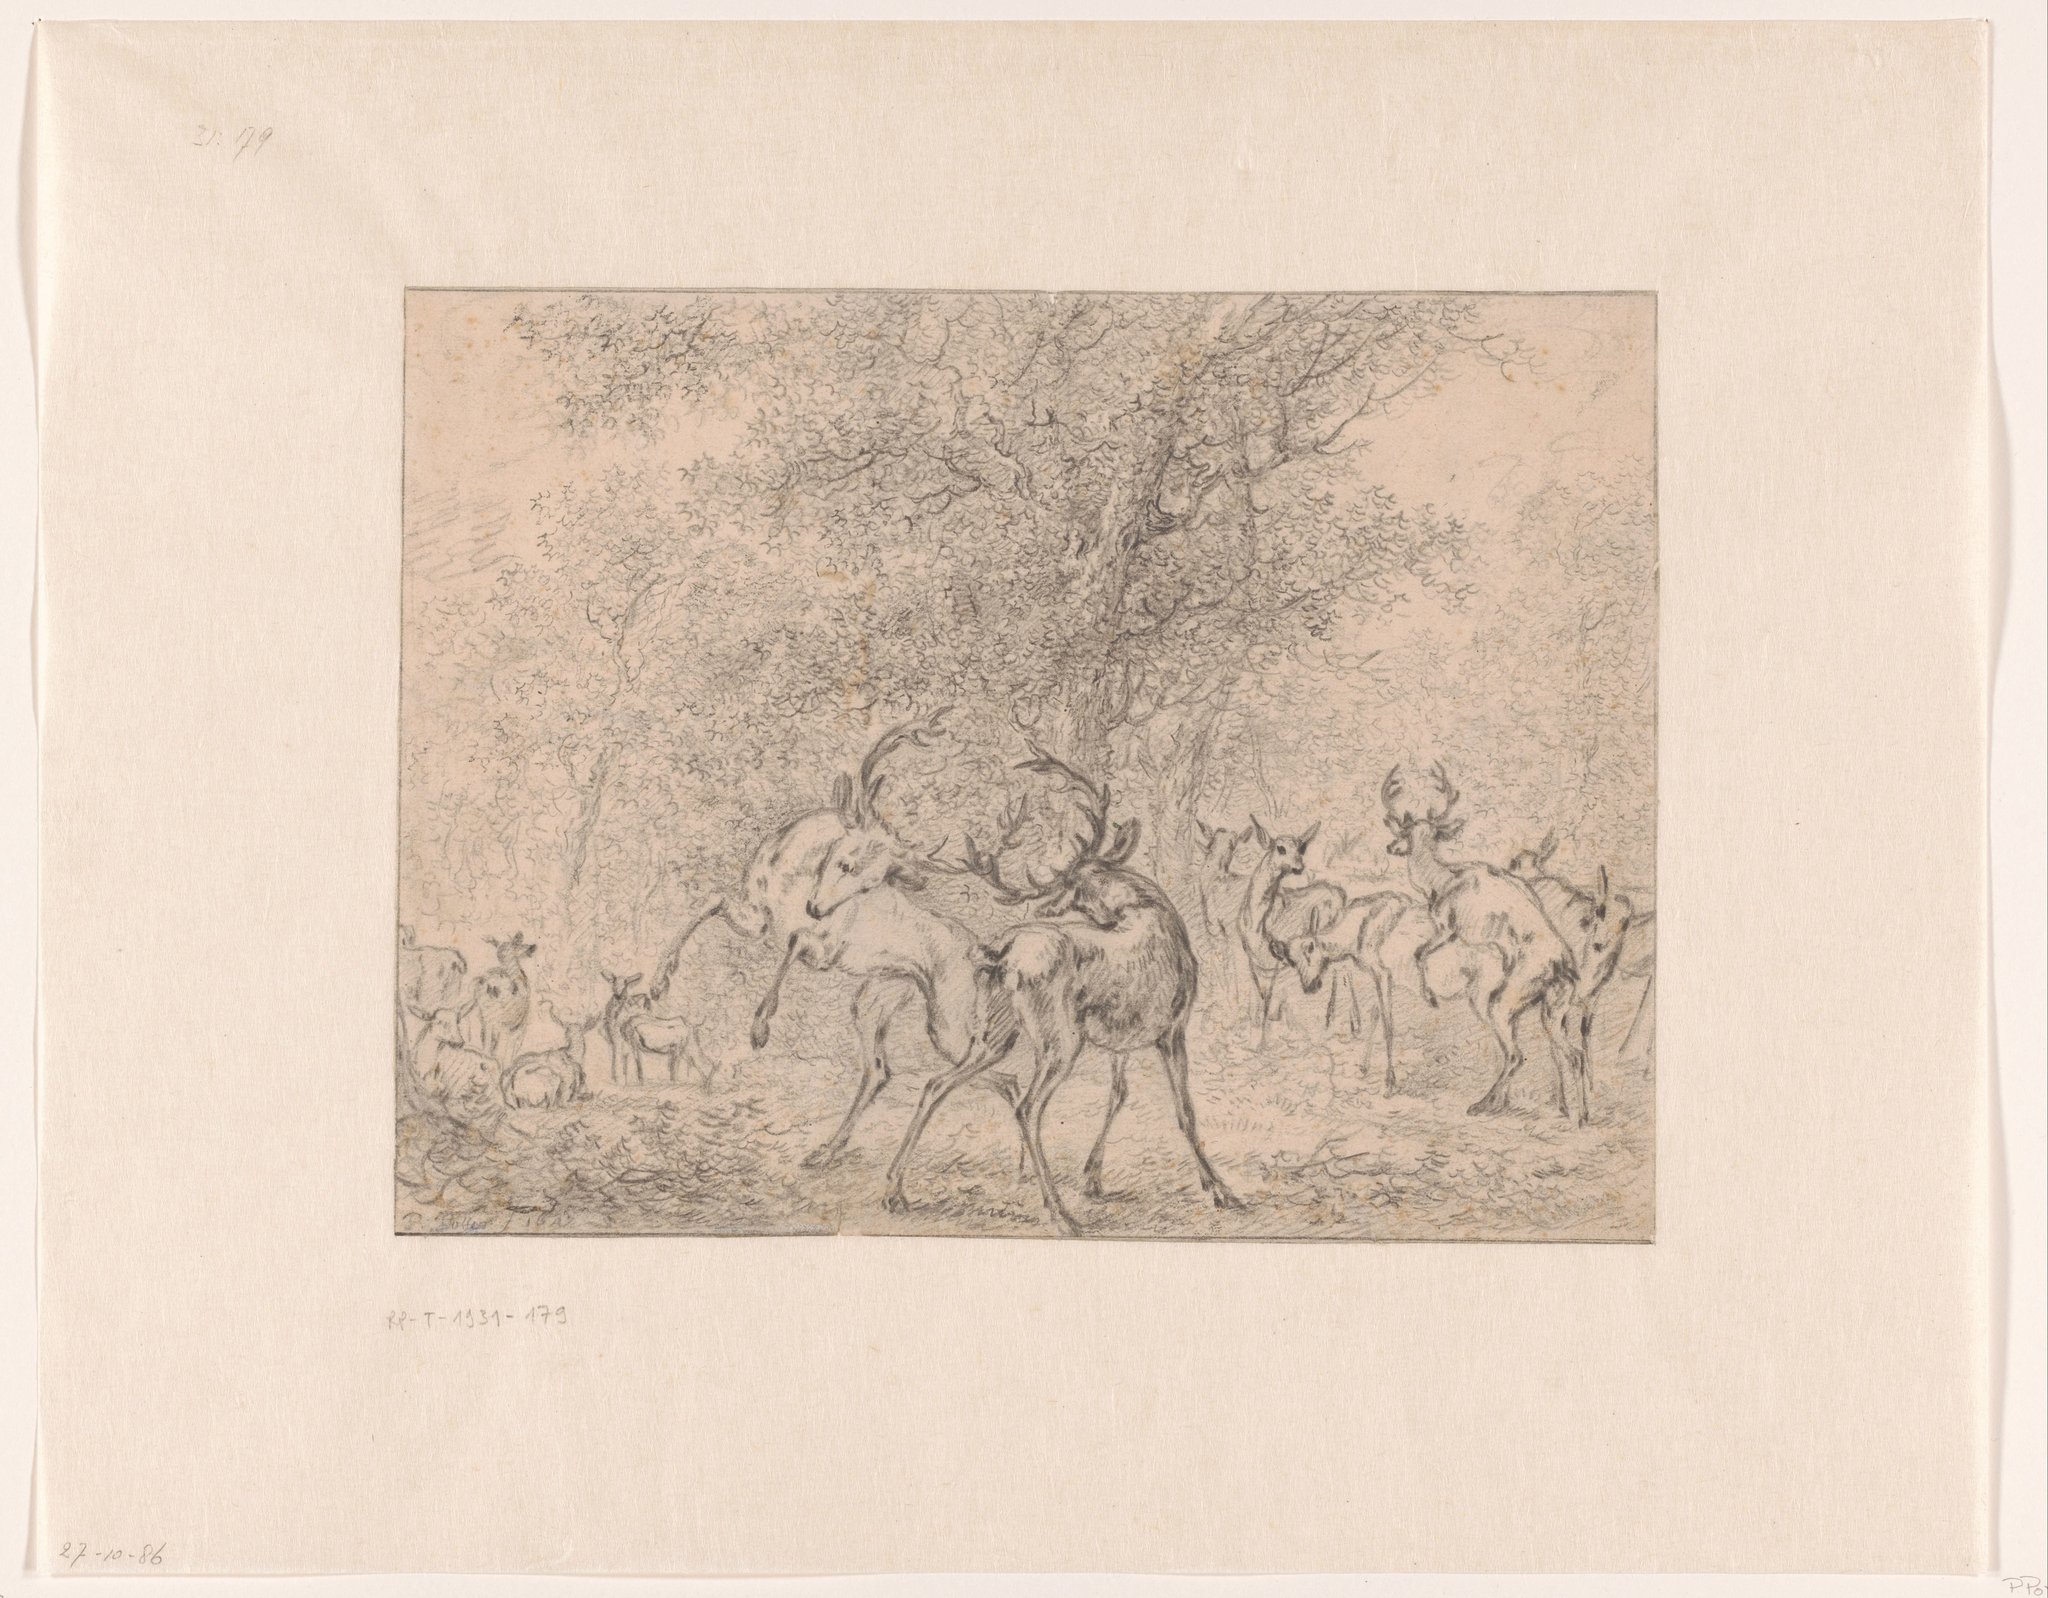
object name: drawing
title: Group of Deer in a Forest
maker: paulus potter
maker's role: draughtsman, painter, print maker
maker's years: 1625-1654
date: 1647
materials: chalk, paper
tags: 25f24(deer)(+432)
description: By varying the pressure he put on the black chalk while drawing, Potter introduced a surprising amount of depth and movement into this scene. The two fighting stags in the middle of the drawing virtually jump off the paper. This draws attention away from the bawdy detail at the right. This kind of drollery would have amused people in the 17th century.